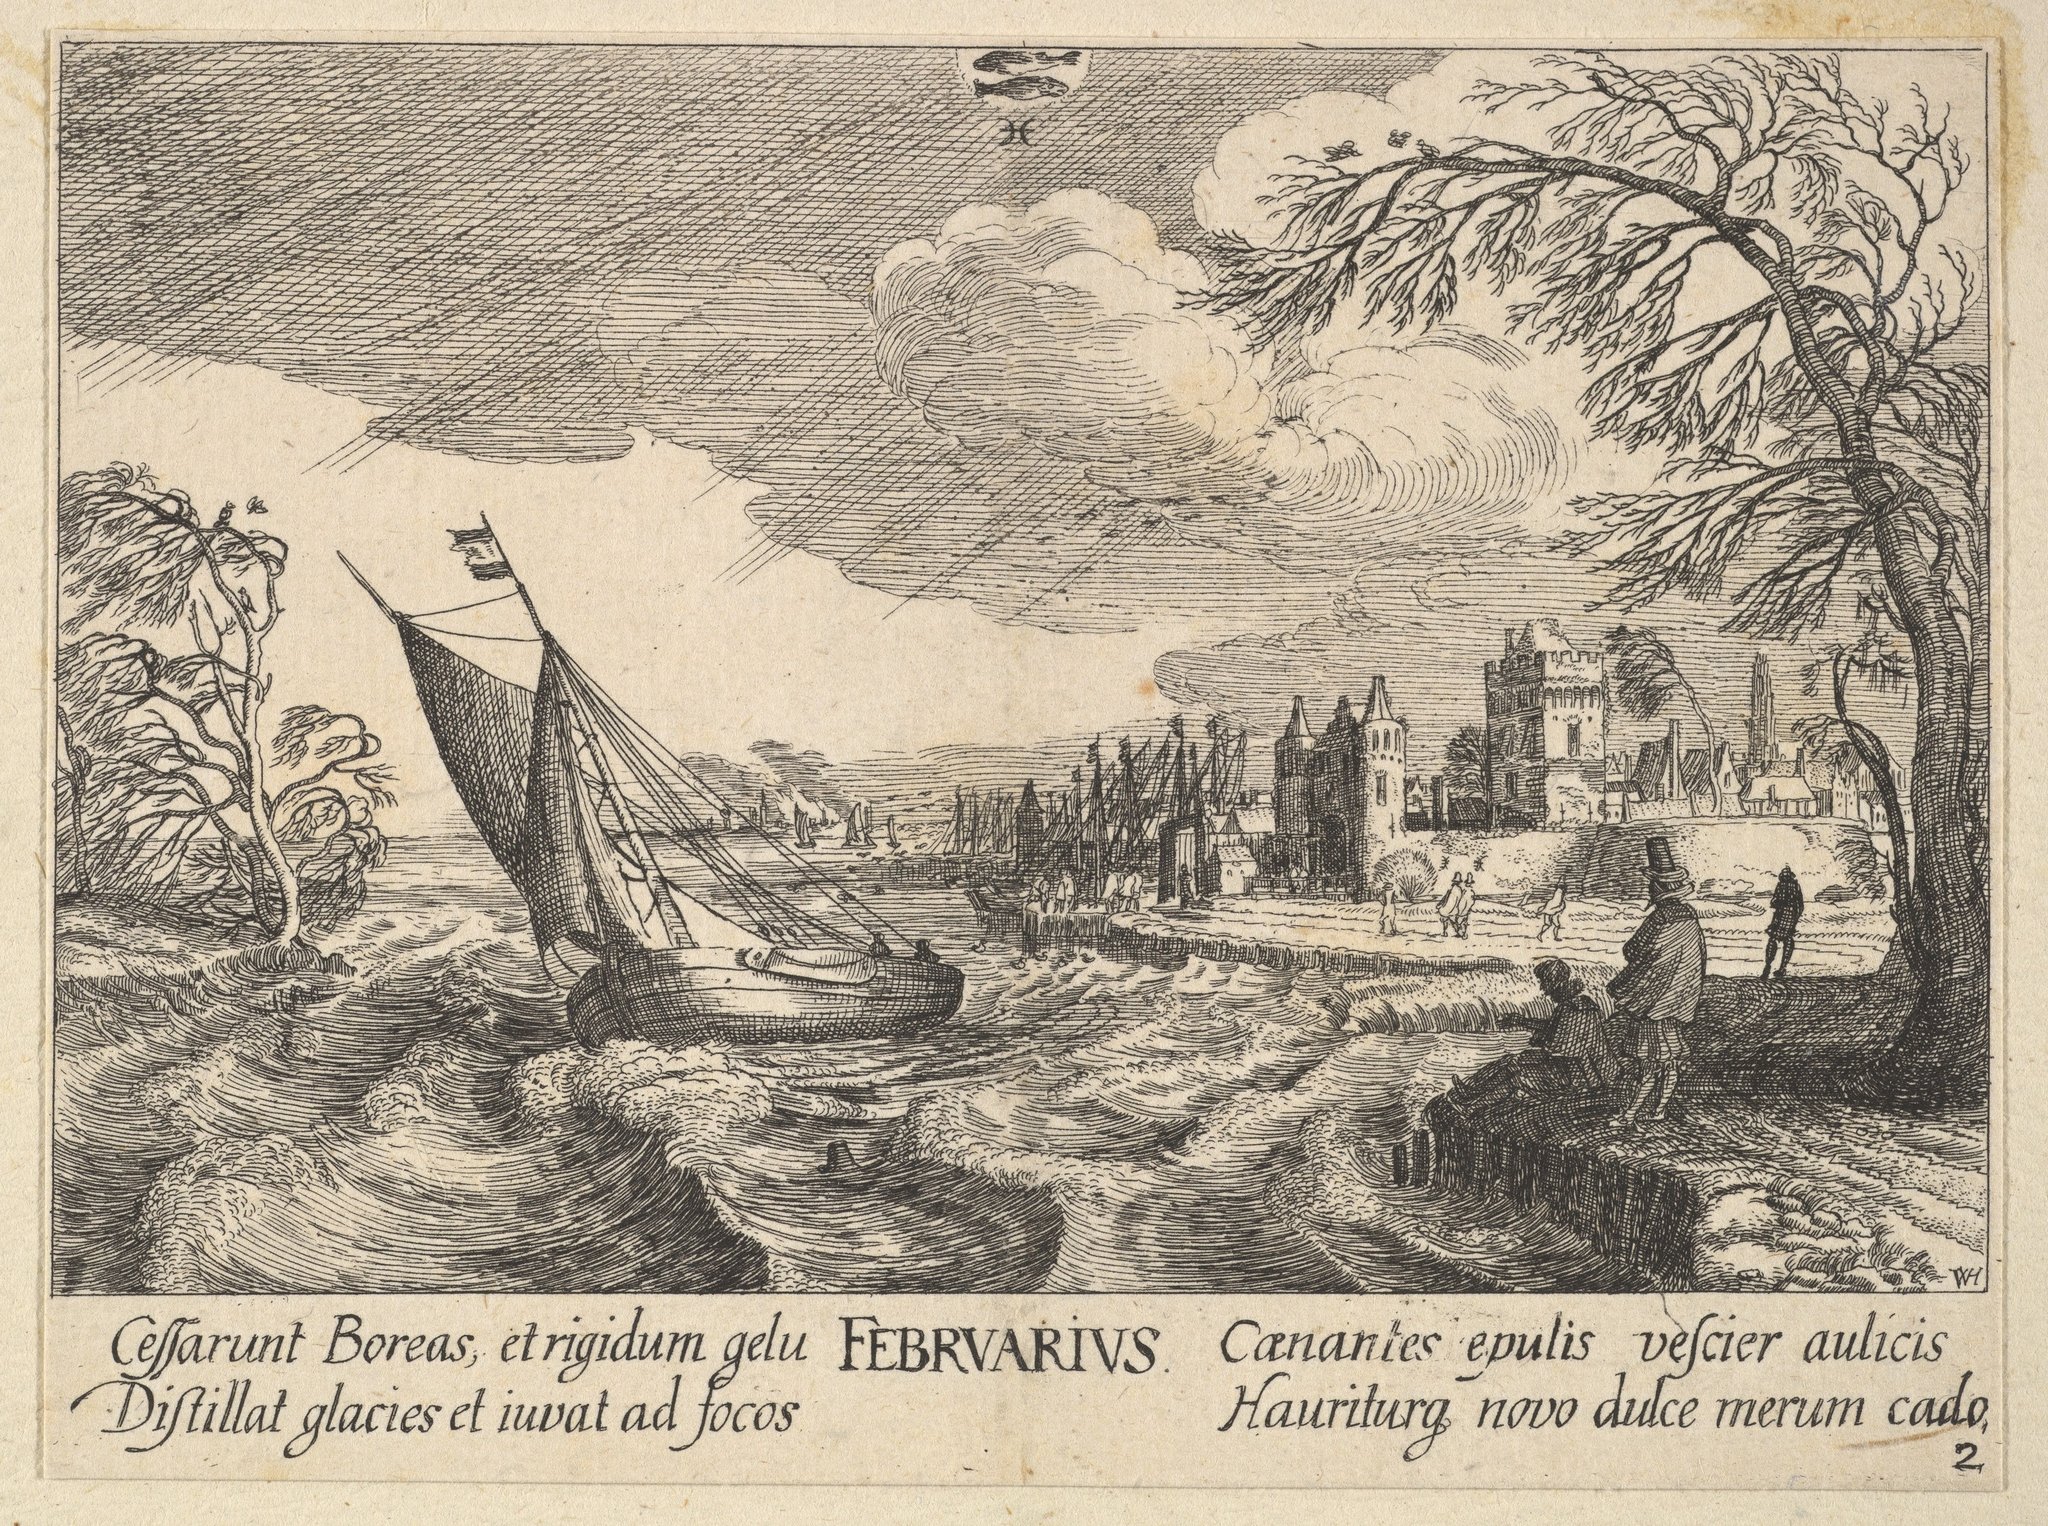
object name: print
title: February (Februarius)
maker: wenceslaus hollar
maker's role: artist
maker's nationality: bohemian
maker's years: 1607-1677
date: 1628-1629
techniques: etching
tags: buildings,rivers,ships